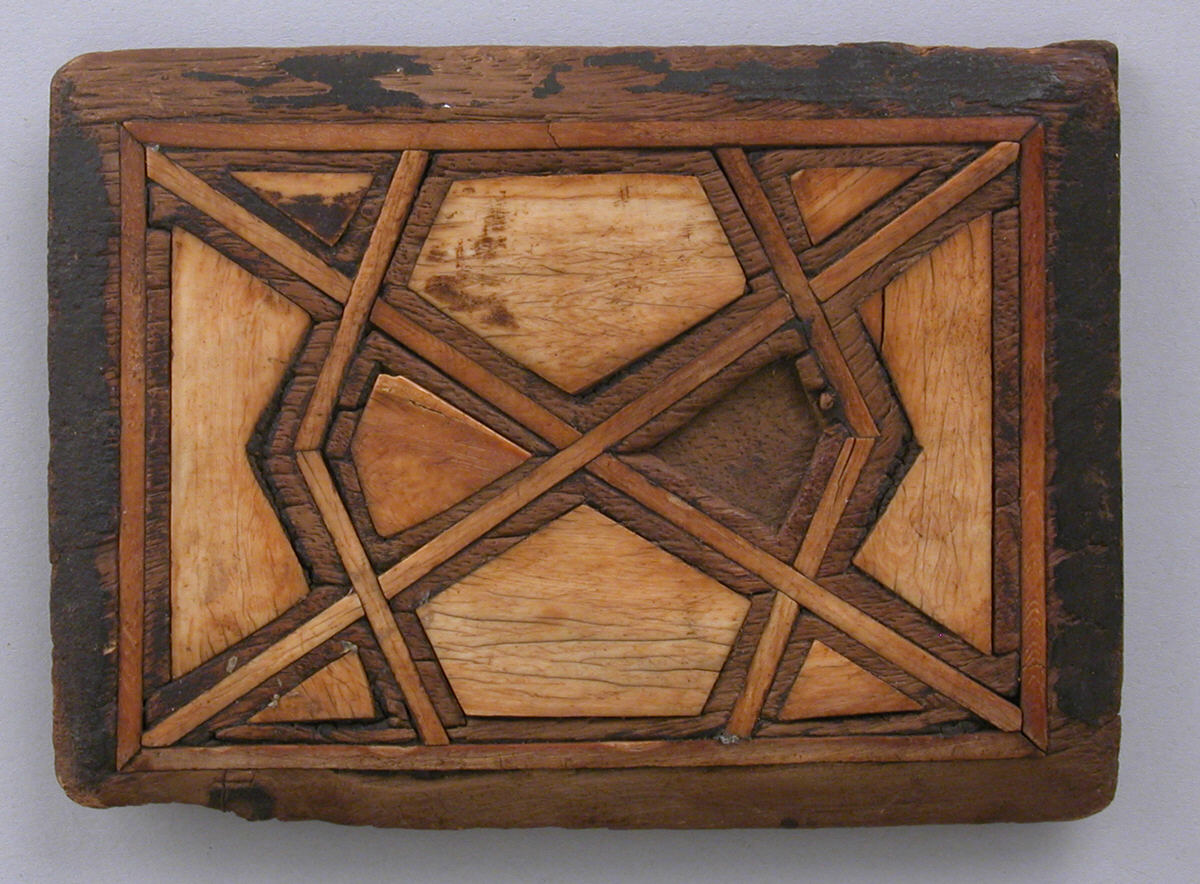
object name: panel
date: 1301-1500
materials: ivory, wood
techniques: carving, inlay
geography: egypt